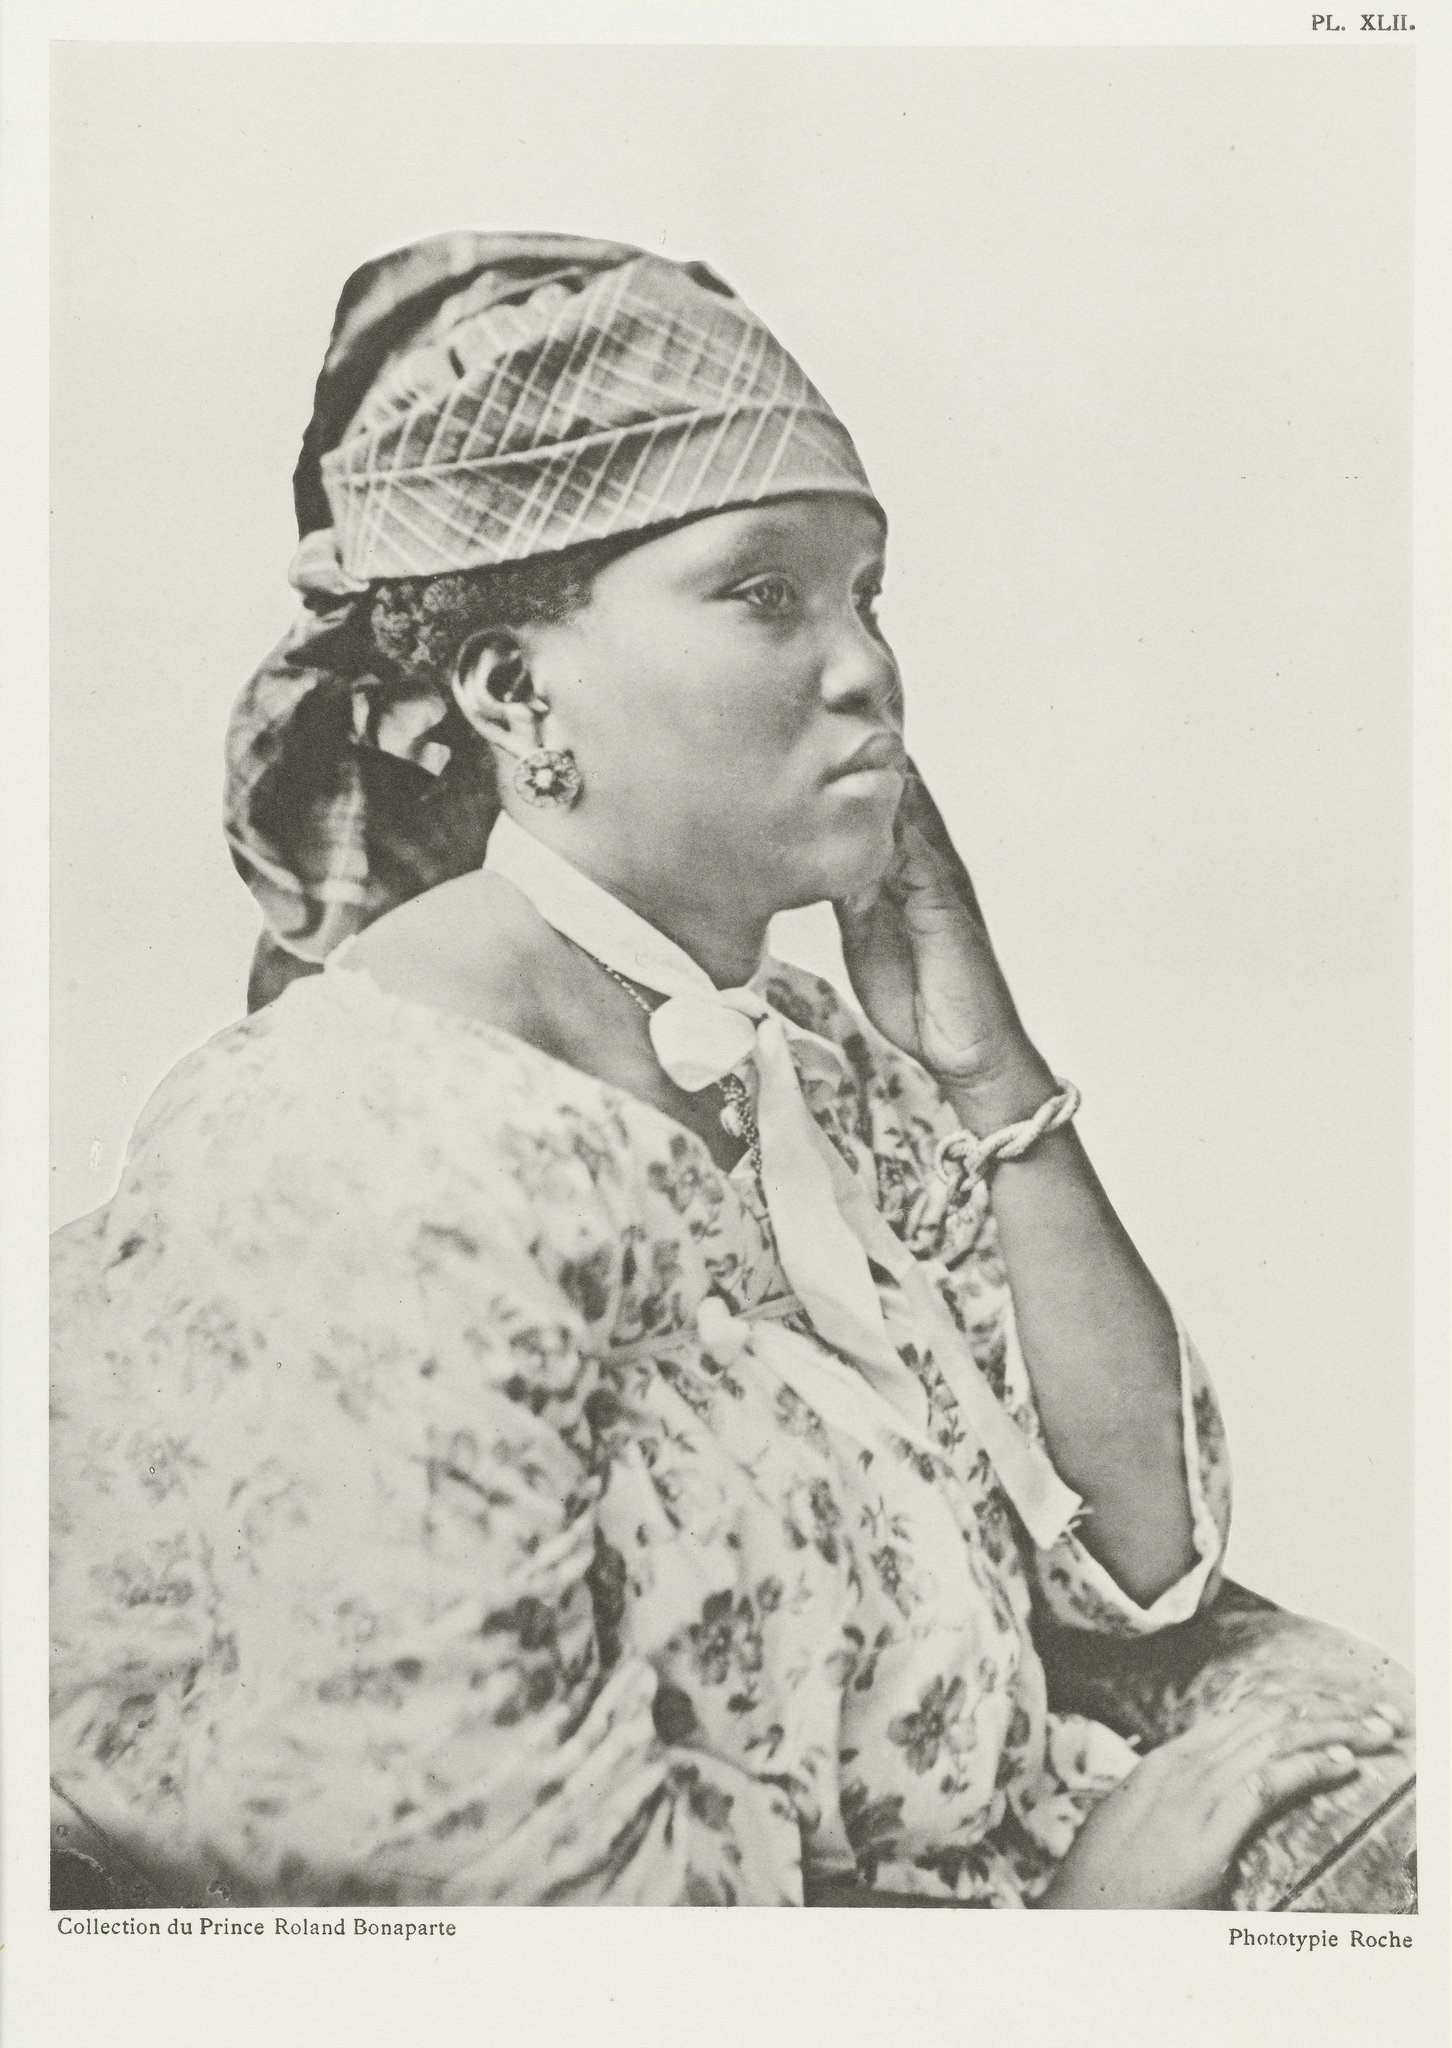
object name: photomechanical print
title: Portret van Jacqueline Ricket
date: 1883-1884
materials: paper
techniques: photograph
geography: amsterdam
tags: adult woman, historical persons, folk costume, regional costume, amsterdam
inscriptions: inscription: ‘Collection du Prince Roland Bonaparte/ Phototypie Roche’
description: Portret van Jacqueline Ricket, een Surinaamse vrouw van Afrikaanse oorsprong, gefotografeerd op de Internationale Koloniale en Uitvoerhandel Tentoonstelling, Amsterdam 1883.